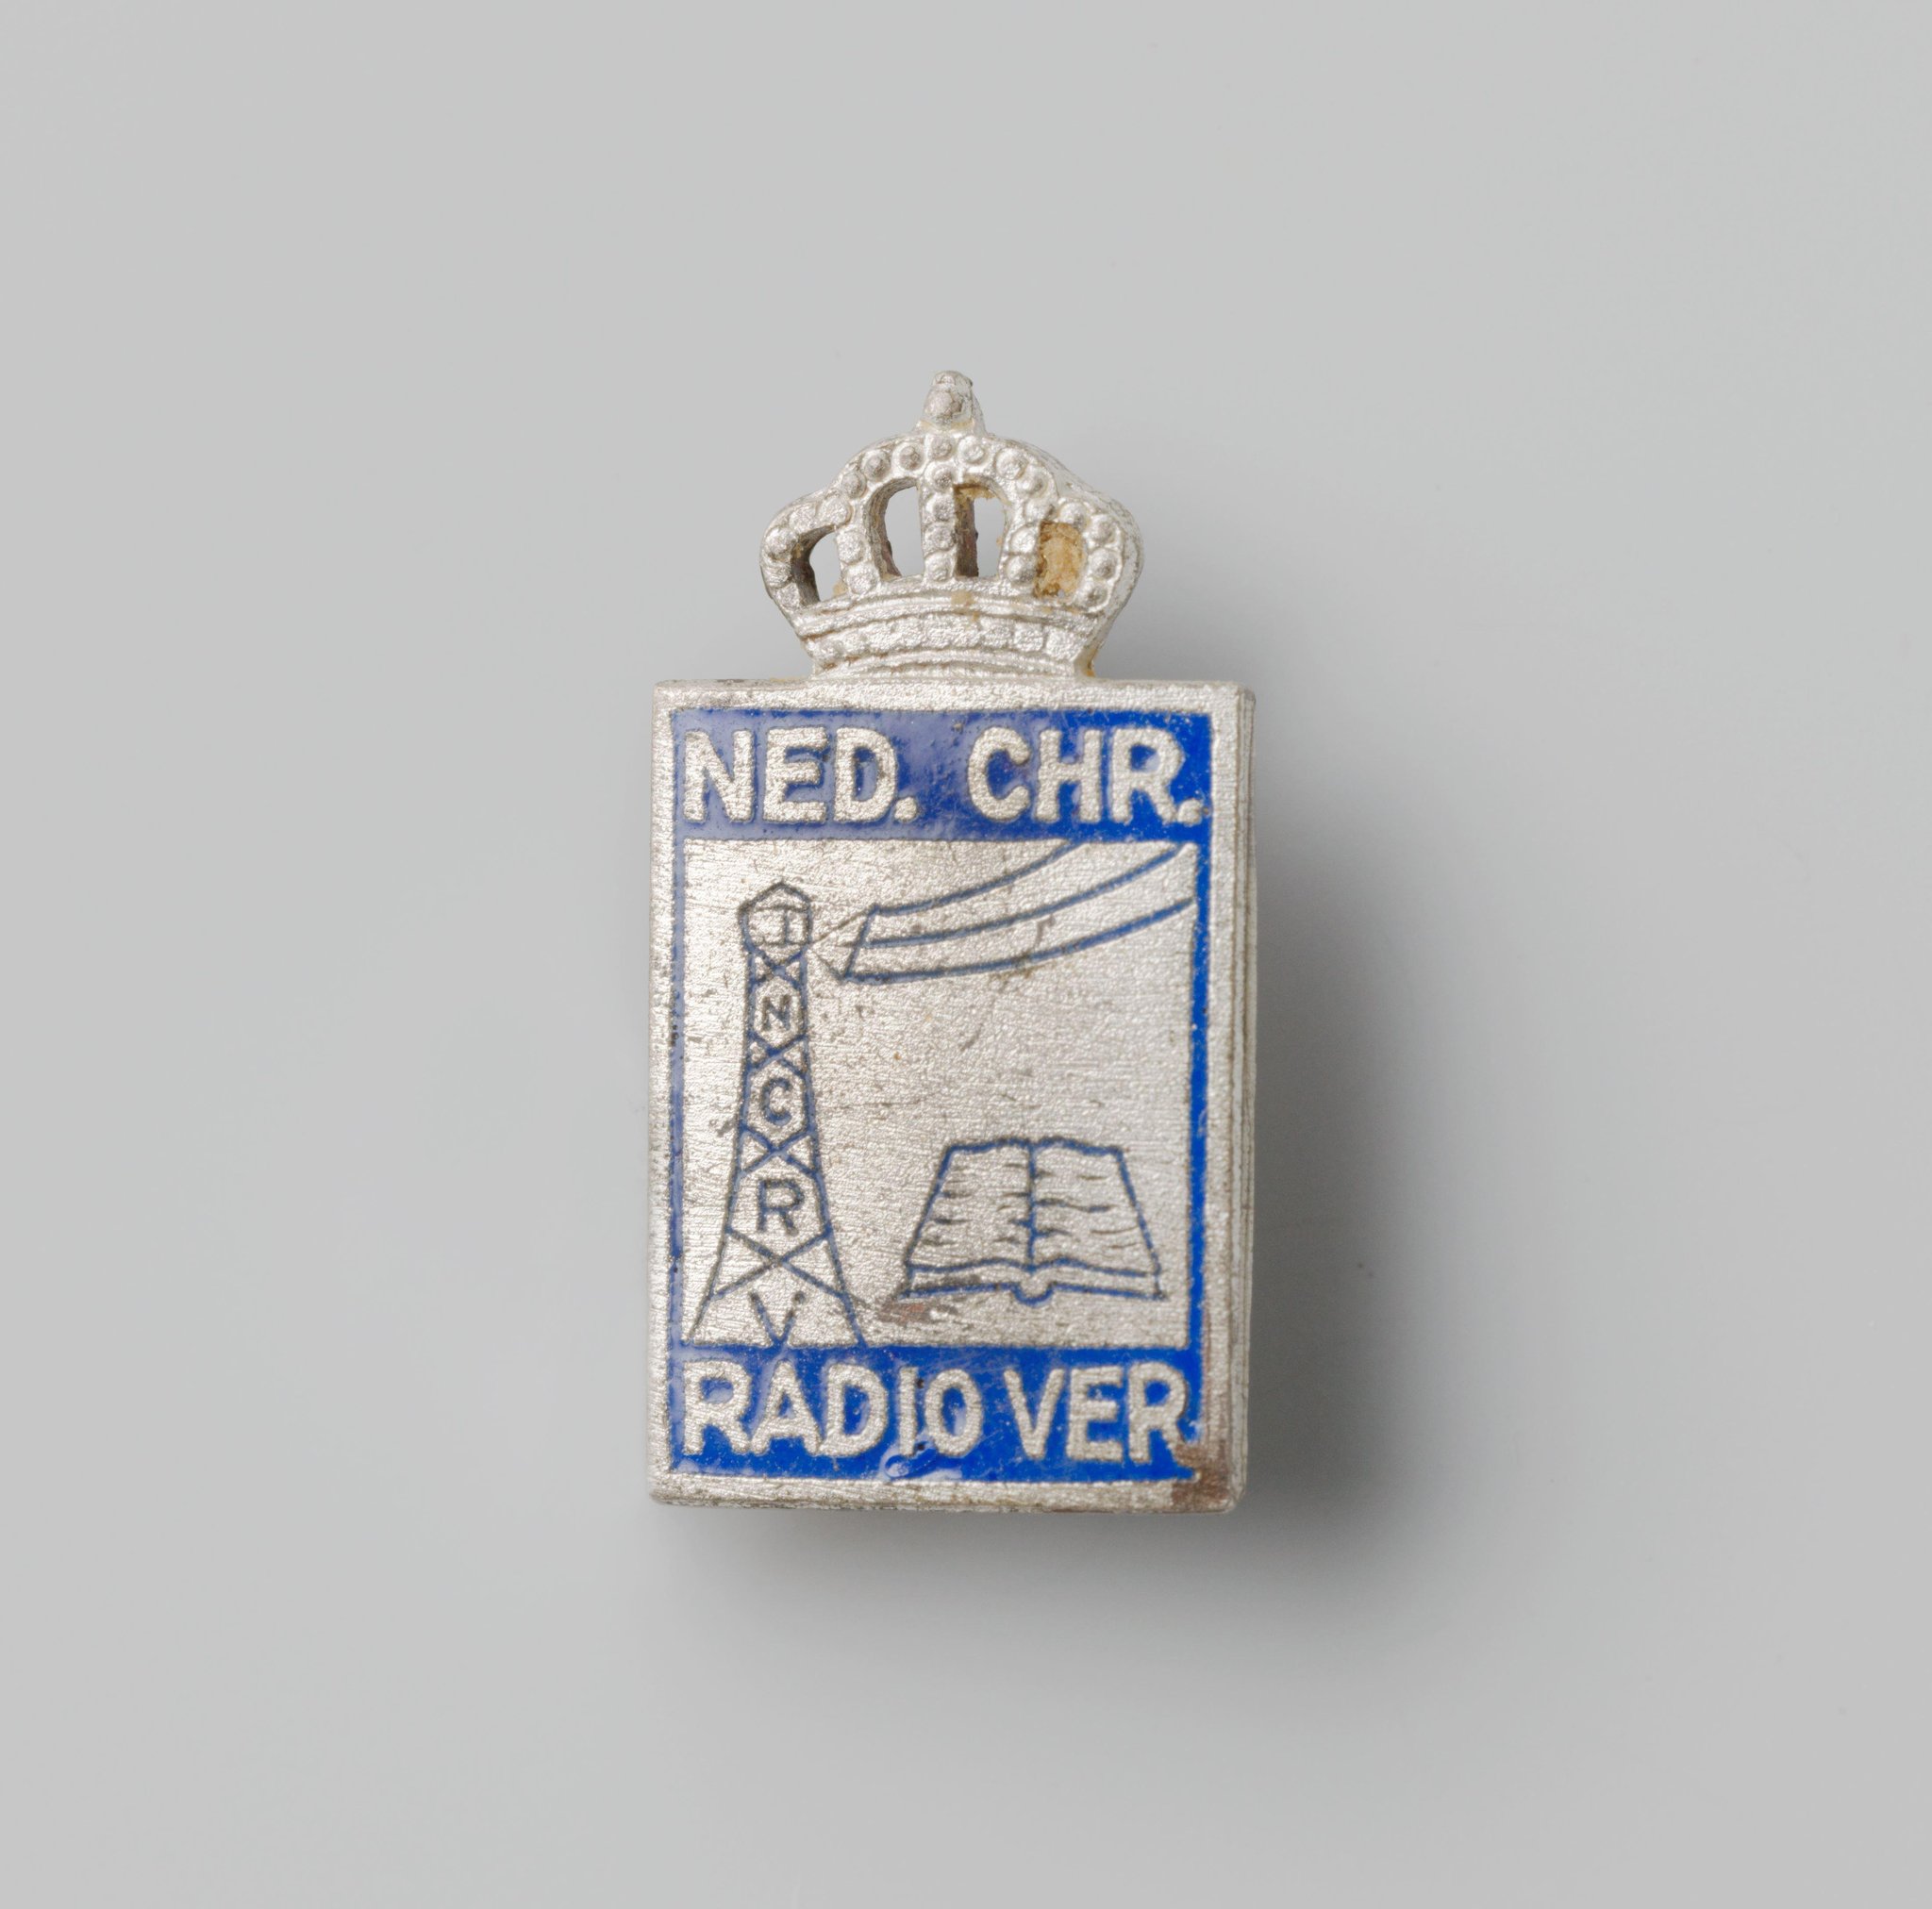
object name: lapel pin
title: Reversspeld van de Nederlandse Christelijke Radio Vereniging (NCRV)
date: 1924-1994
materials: metal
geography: netherlands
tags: netherlands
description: Rechthoekige speld met een kroon erboven op. Op de rechthoek staat, tussen het opschrift, een zendmast met de letters N / C / R / V (van boven naar beneden). Hiernaast staat een opengeslagen boek. Opschrift: NED. CHR. / RADIO VER. De speld is van metaal met blauw als steunkleur. Op de keerzijde zit een veiligeheidsspeld.